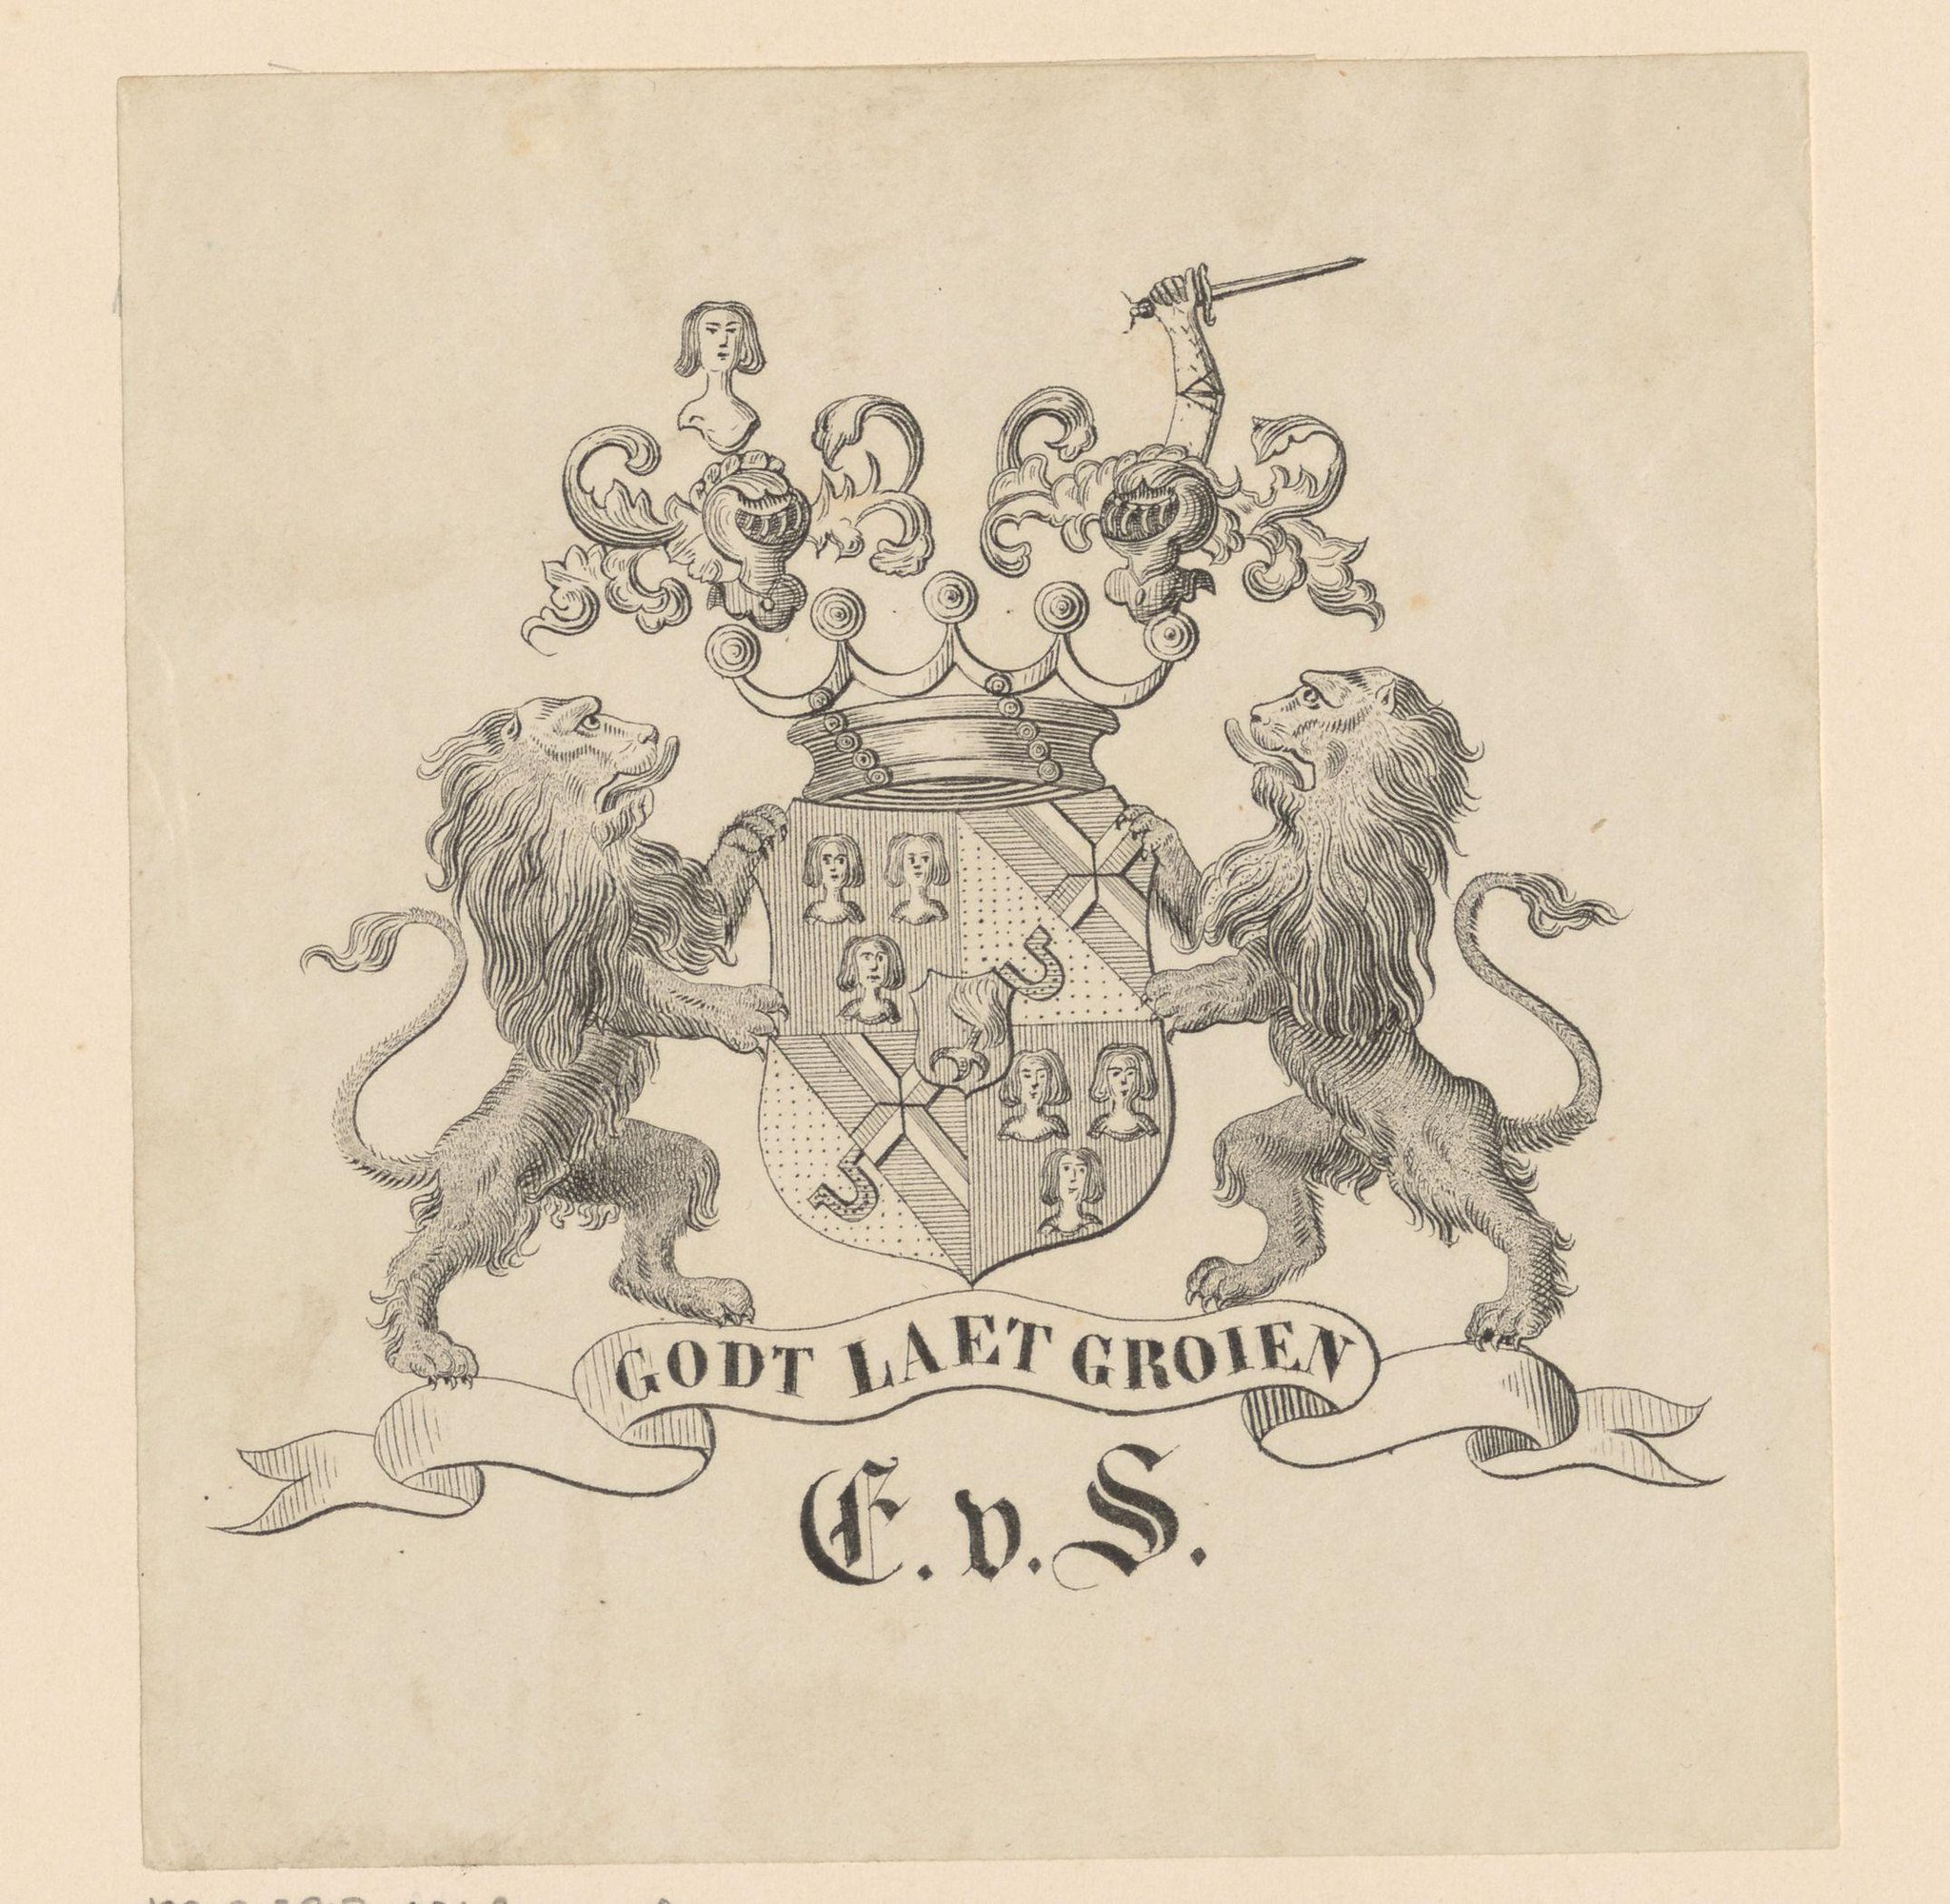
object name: bookplate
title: Ex libris van E.v.S.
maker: Anonymous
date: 1800-1899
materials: paper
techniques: etching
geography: netherlands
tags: head (human) - aa - female human figure, beasts of prey, predatory animals: lion, armorial bearing, heraldry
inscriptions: inscription: ‘Rietstap, 608.’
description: Ex libris van de familie Elout van Soeterwoude.